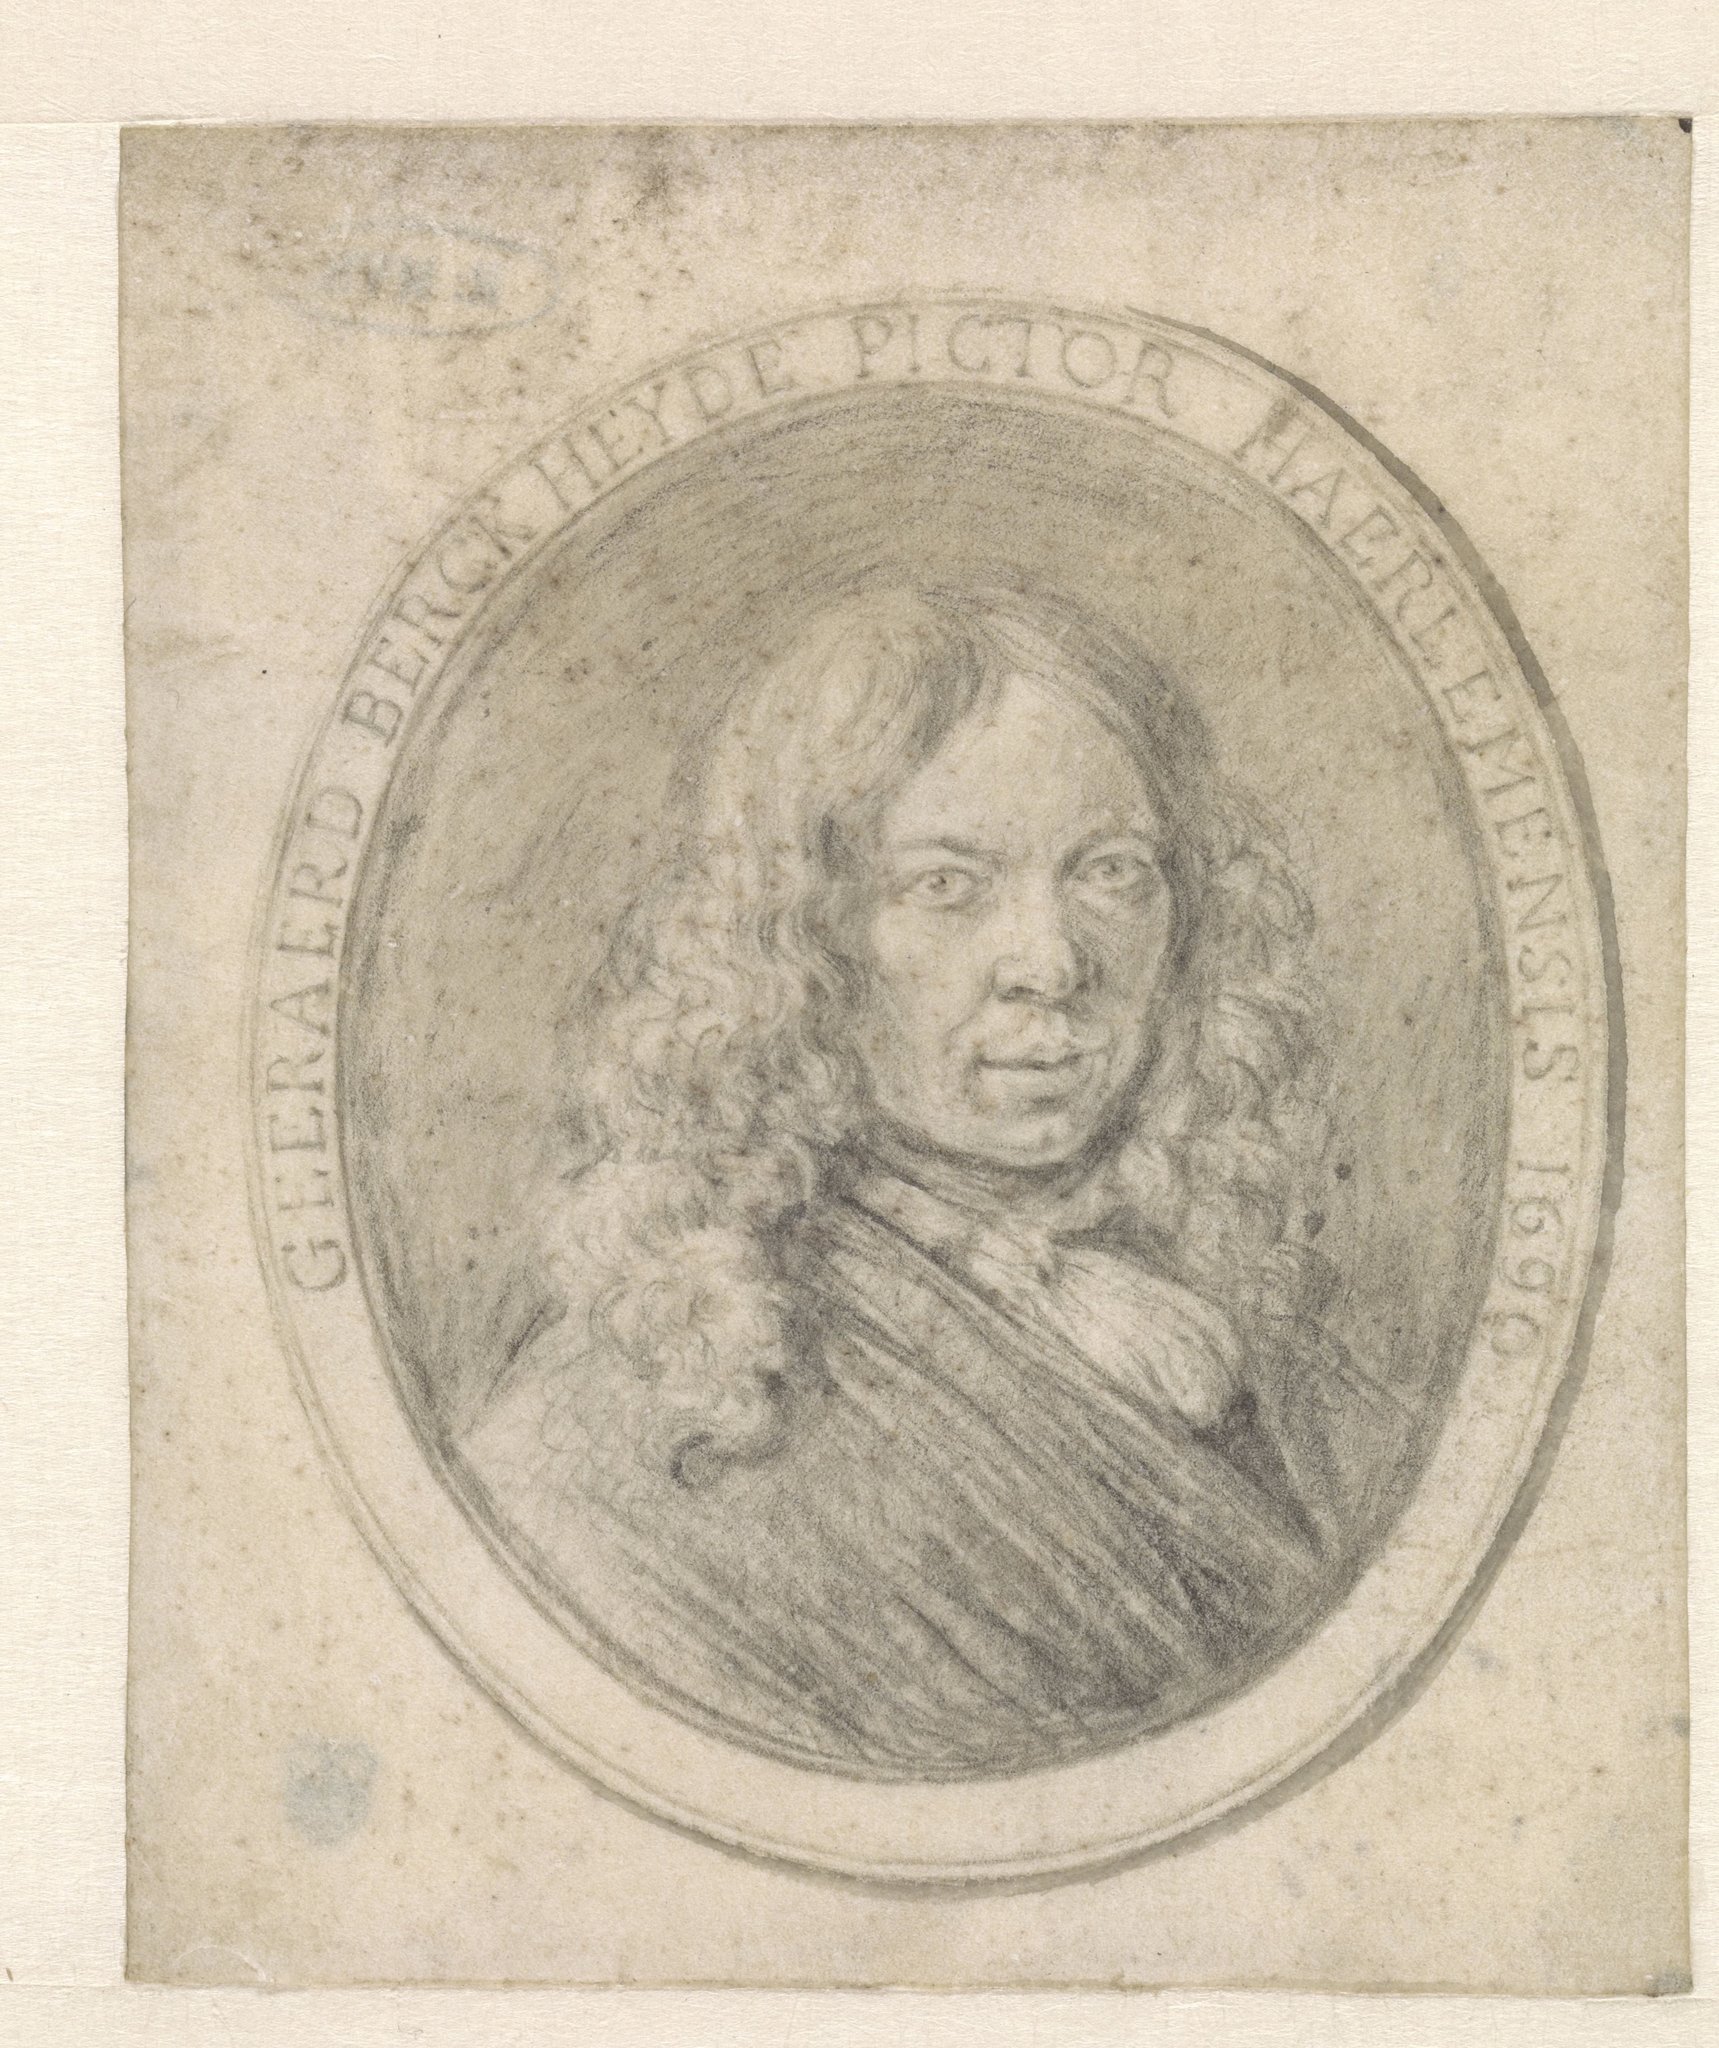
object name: drawing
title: Portret van Gerrit Adriaensz. Berckheyde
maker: Anonymous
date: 1690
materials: parchment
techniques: pen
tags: haarlem, draughtsman, gerrit berckheyde, historical persons, portrait, self-portrait of painter, portrait, self-portrait of artist, portrait, self-portrait of draughtsman